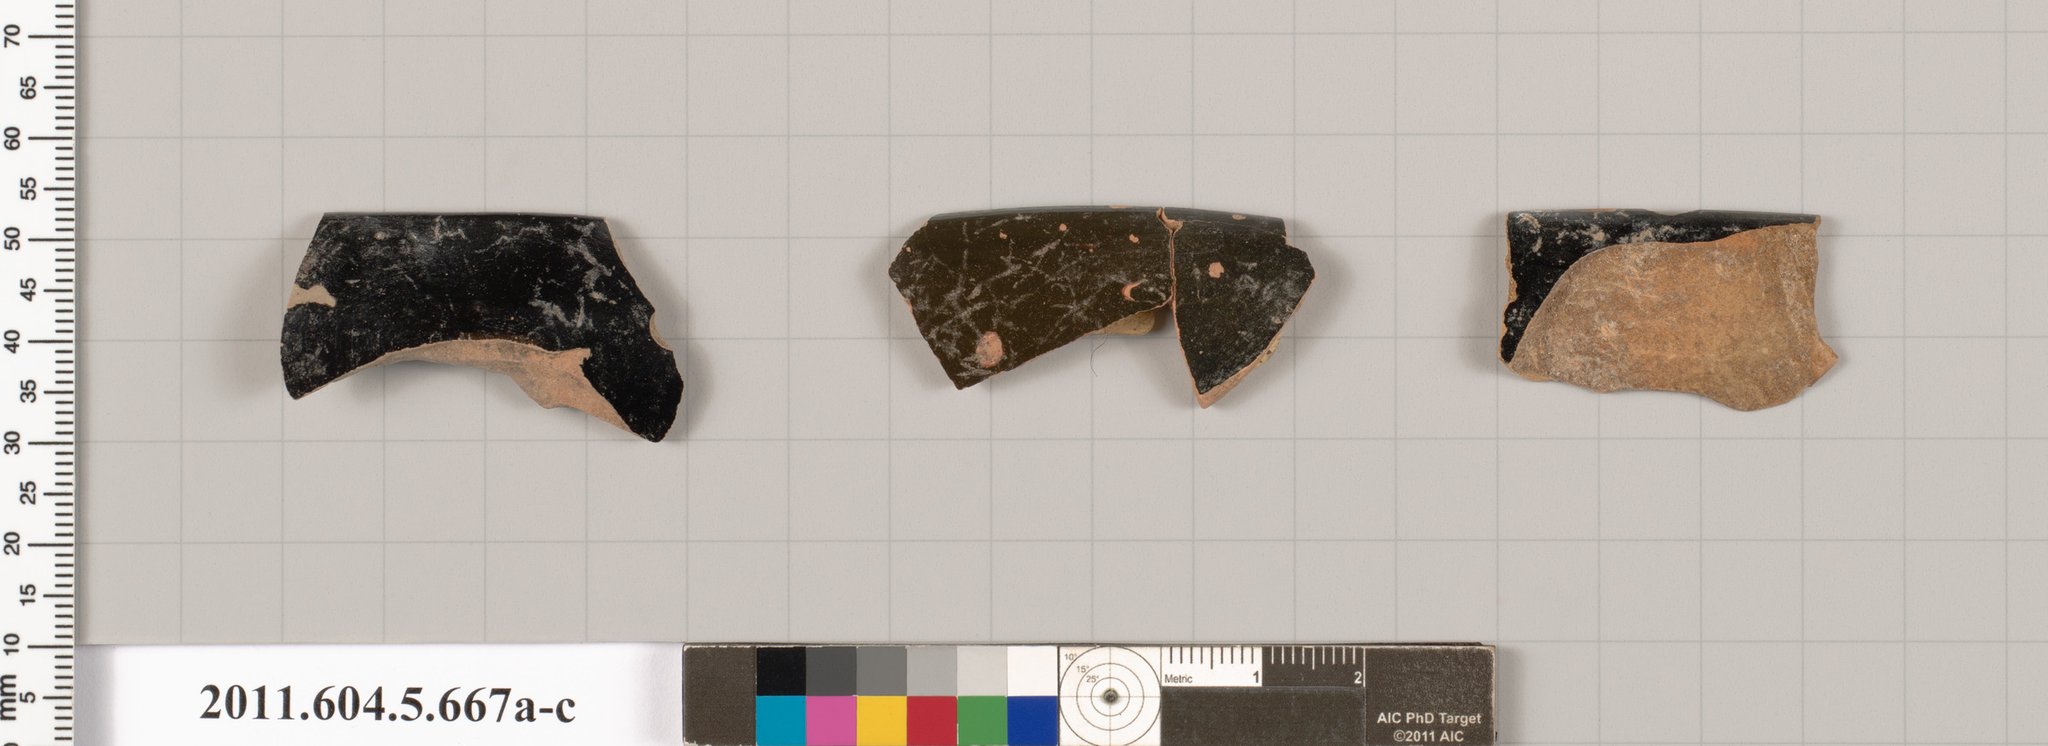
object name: kylix fragment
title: Terracotta rim fragments of kylikes (drinking cups)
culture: greek, attic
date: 600-401 BCE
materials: terracotta